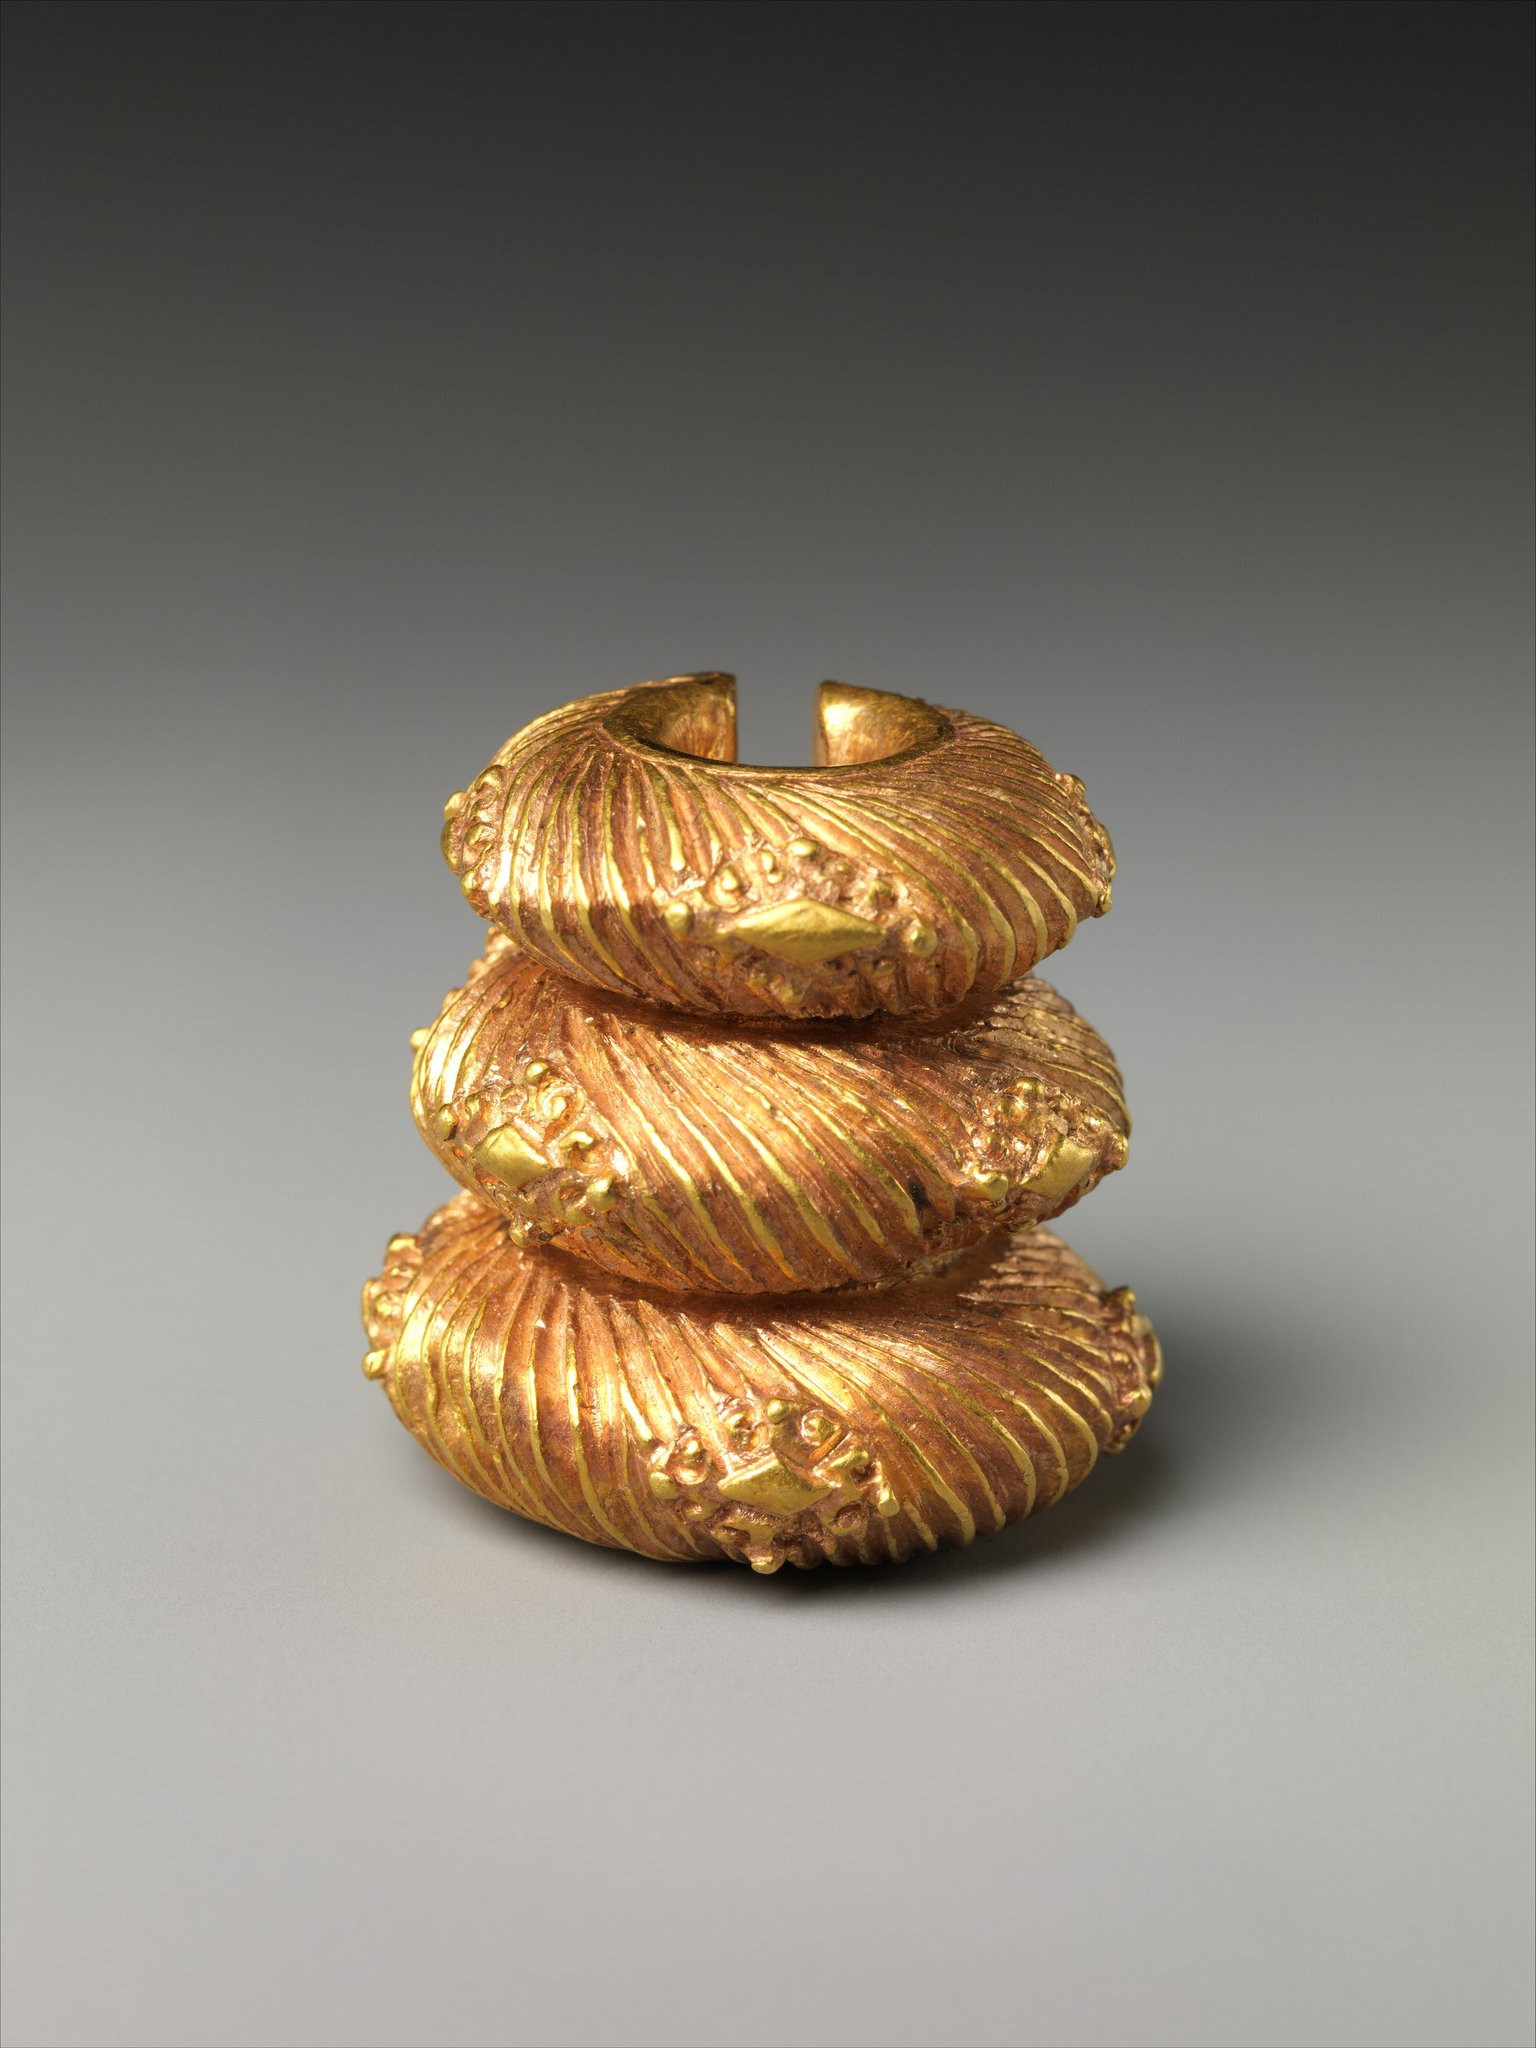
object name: fastener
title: Weighted Fastener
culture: indonesian, javanese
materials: gold